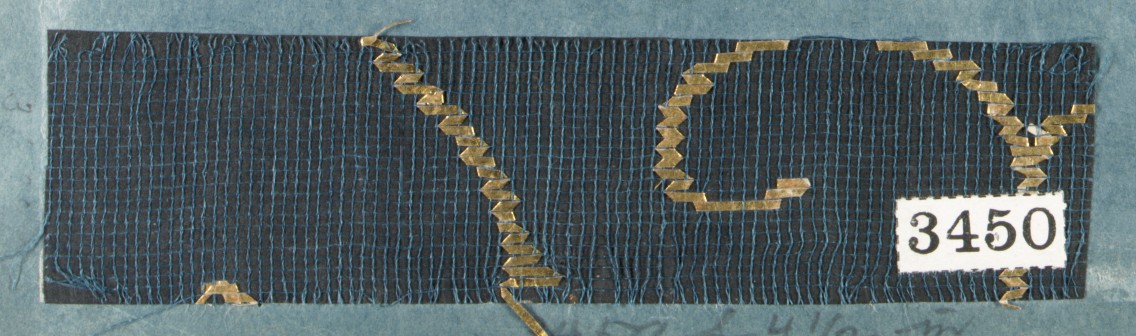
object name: sample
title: Textile Sample from Sample Book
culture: japanese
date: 1801-1900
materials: silk